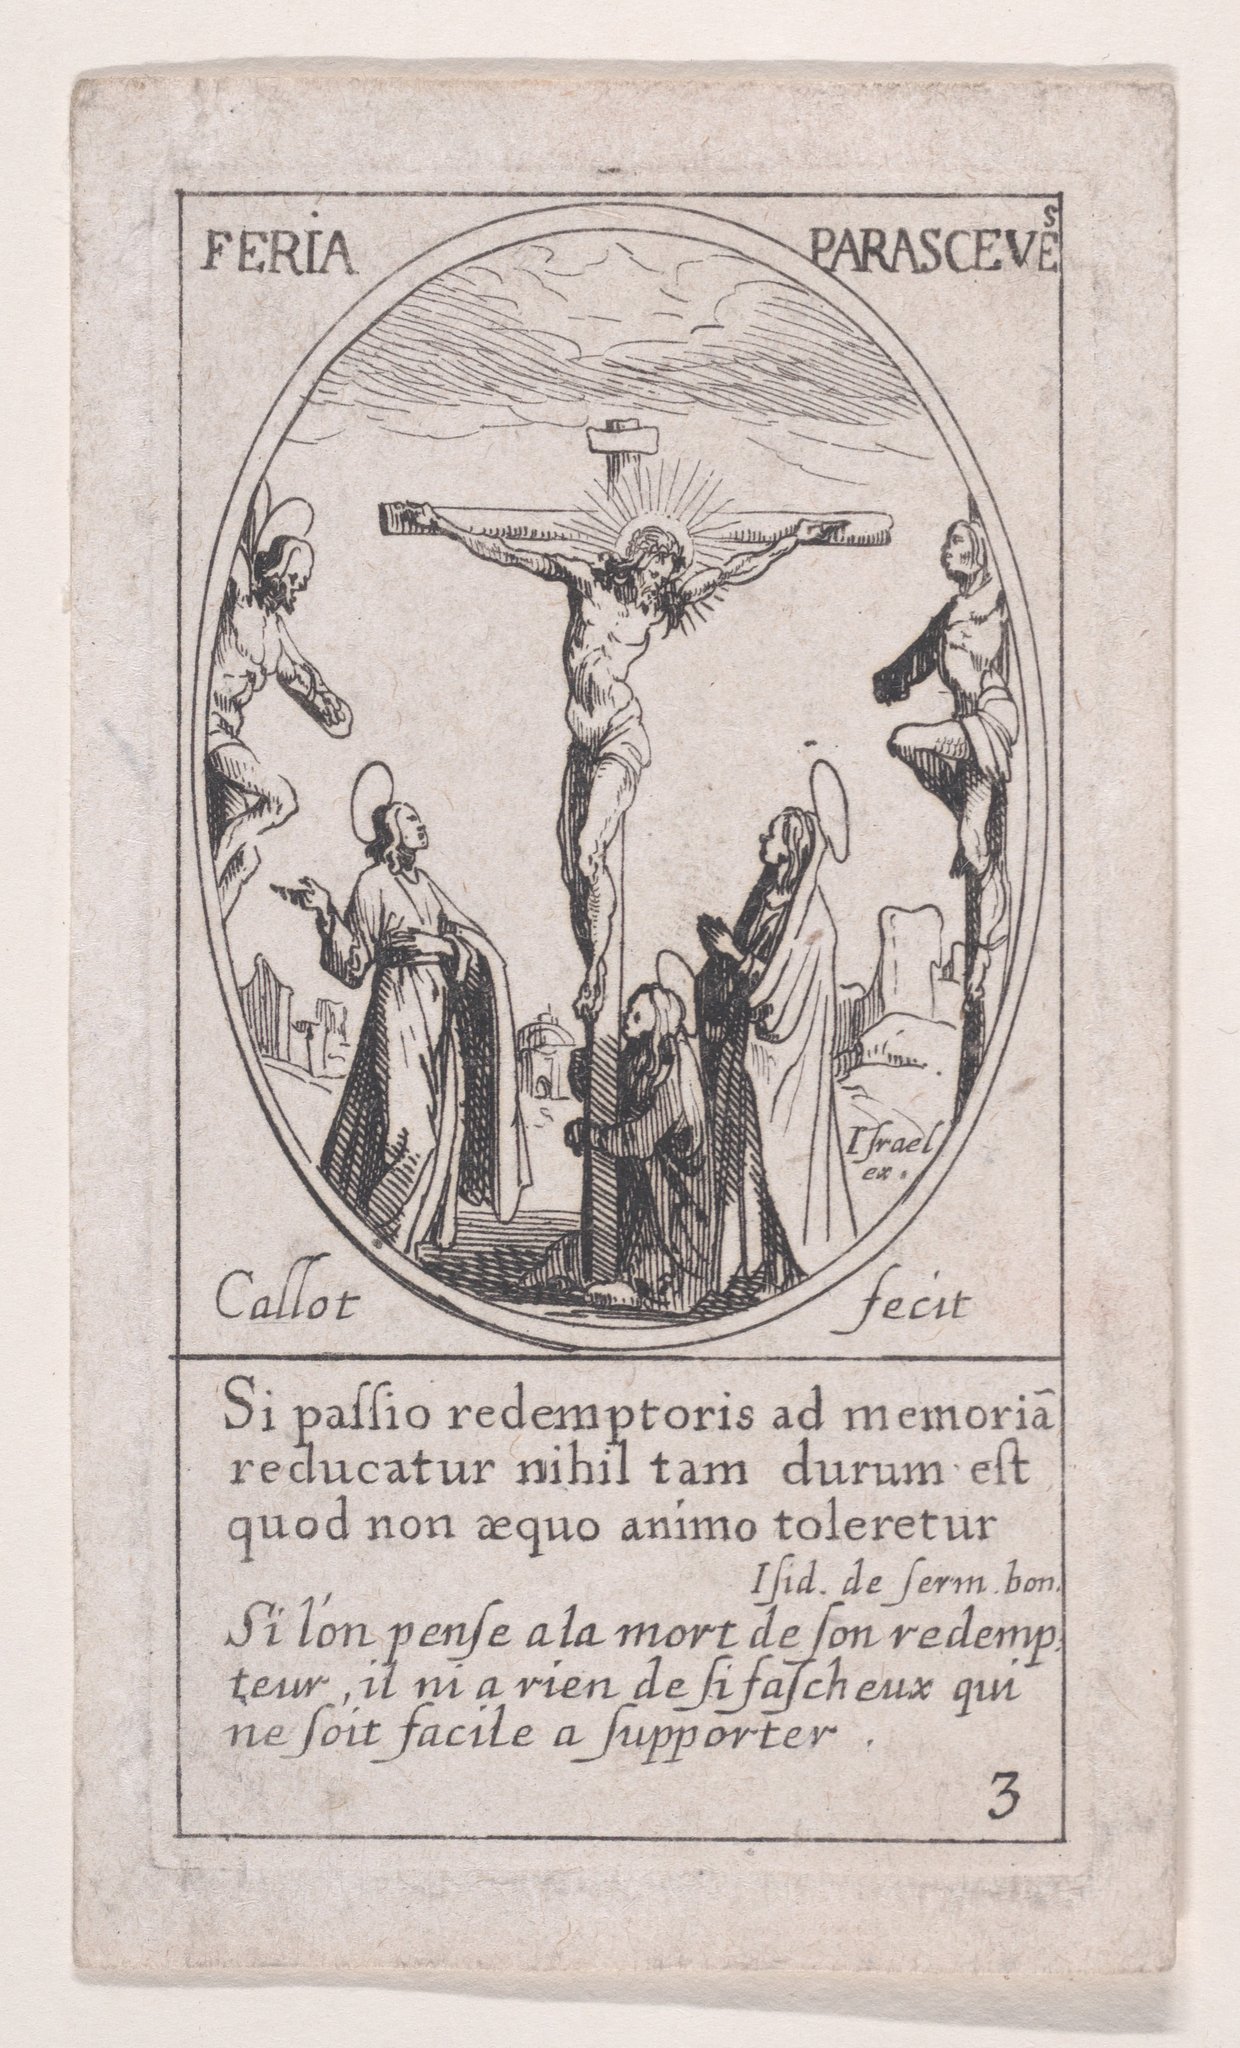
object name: print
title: Jésus-Christ expire sur le croix (Christ on the Cross), Good Friday, scene 3 from Images des Fêtes Mobiles (Images of Moveable Feasts from the Christian Calendar), part of "Les Images De Tous Les Saincts et Saintes de L'Année" (Images of All of the Saints and Religious Events of the Year)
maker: jacques callot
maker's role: artist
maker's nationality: french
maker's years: 1592-1635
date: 1632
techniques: etching